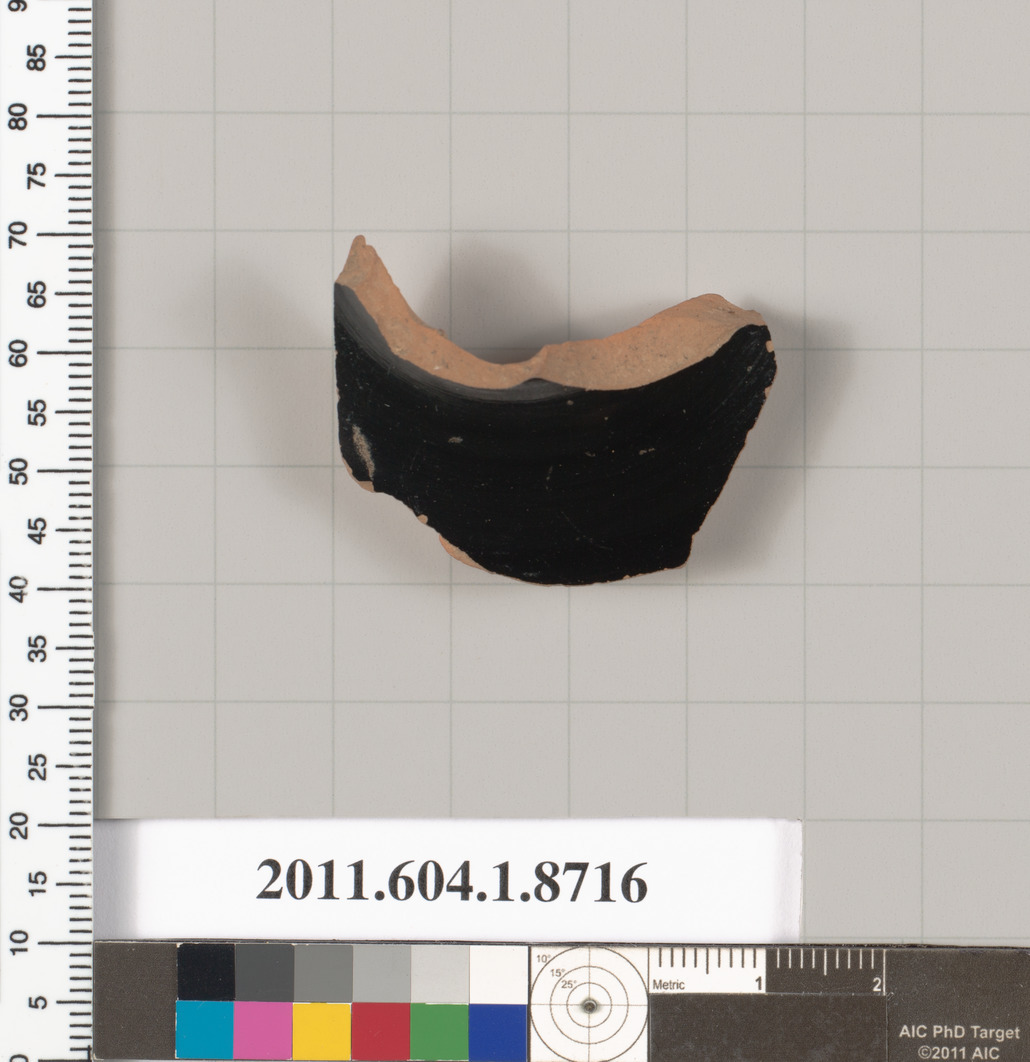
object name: kylix fragment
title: Terracotta fragment of a kylix (drinking cup)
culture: greek, attic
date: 600-401 BCE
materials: terracotta